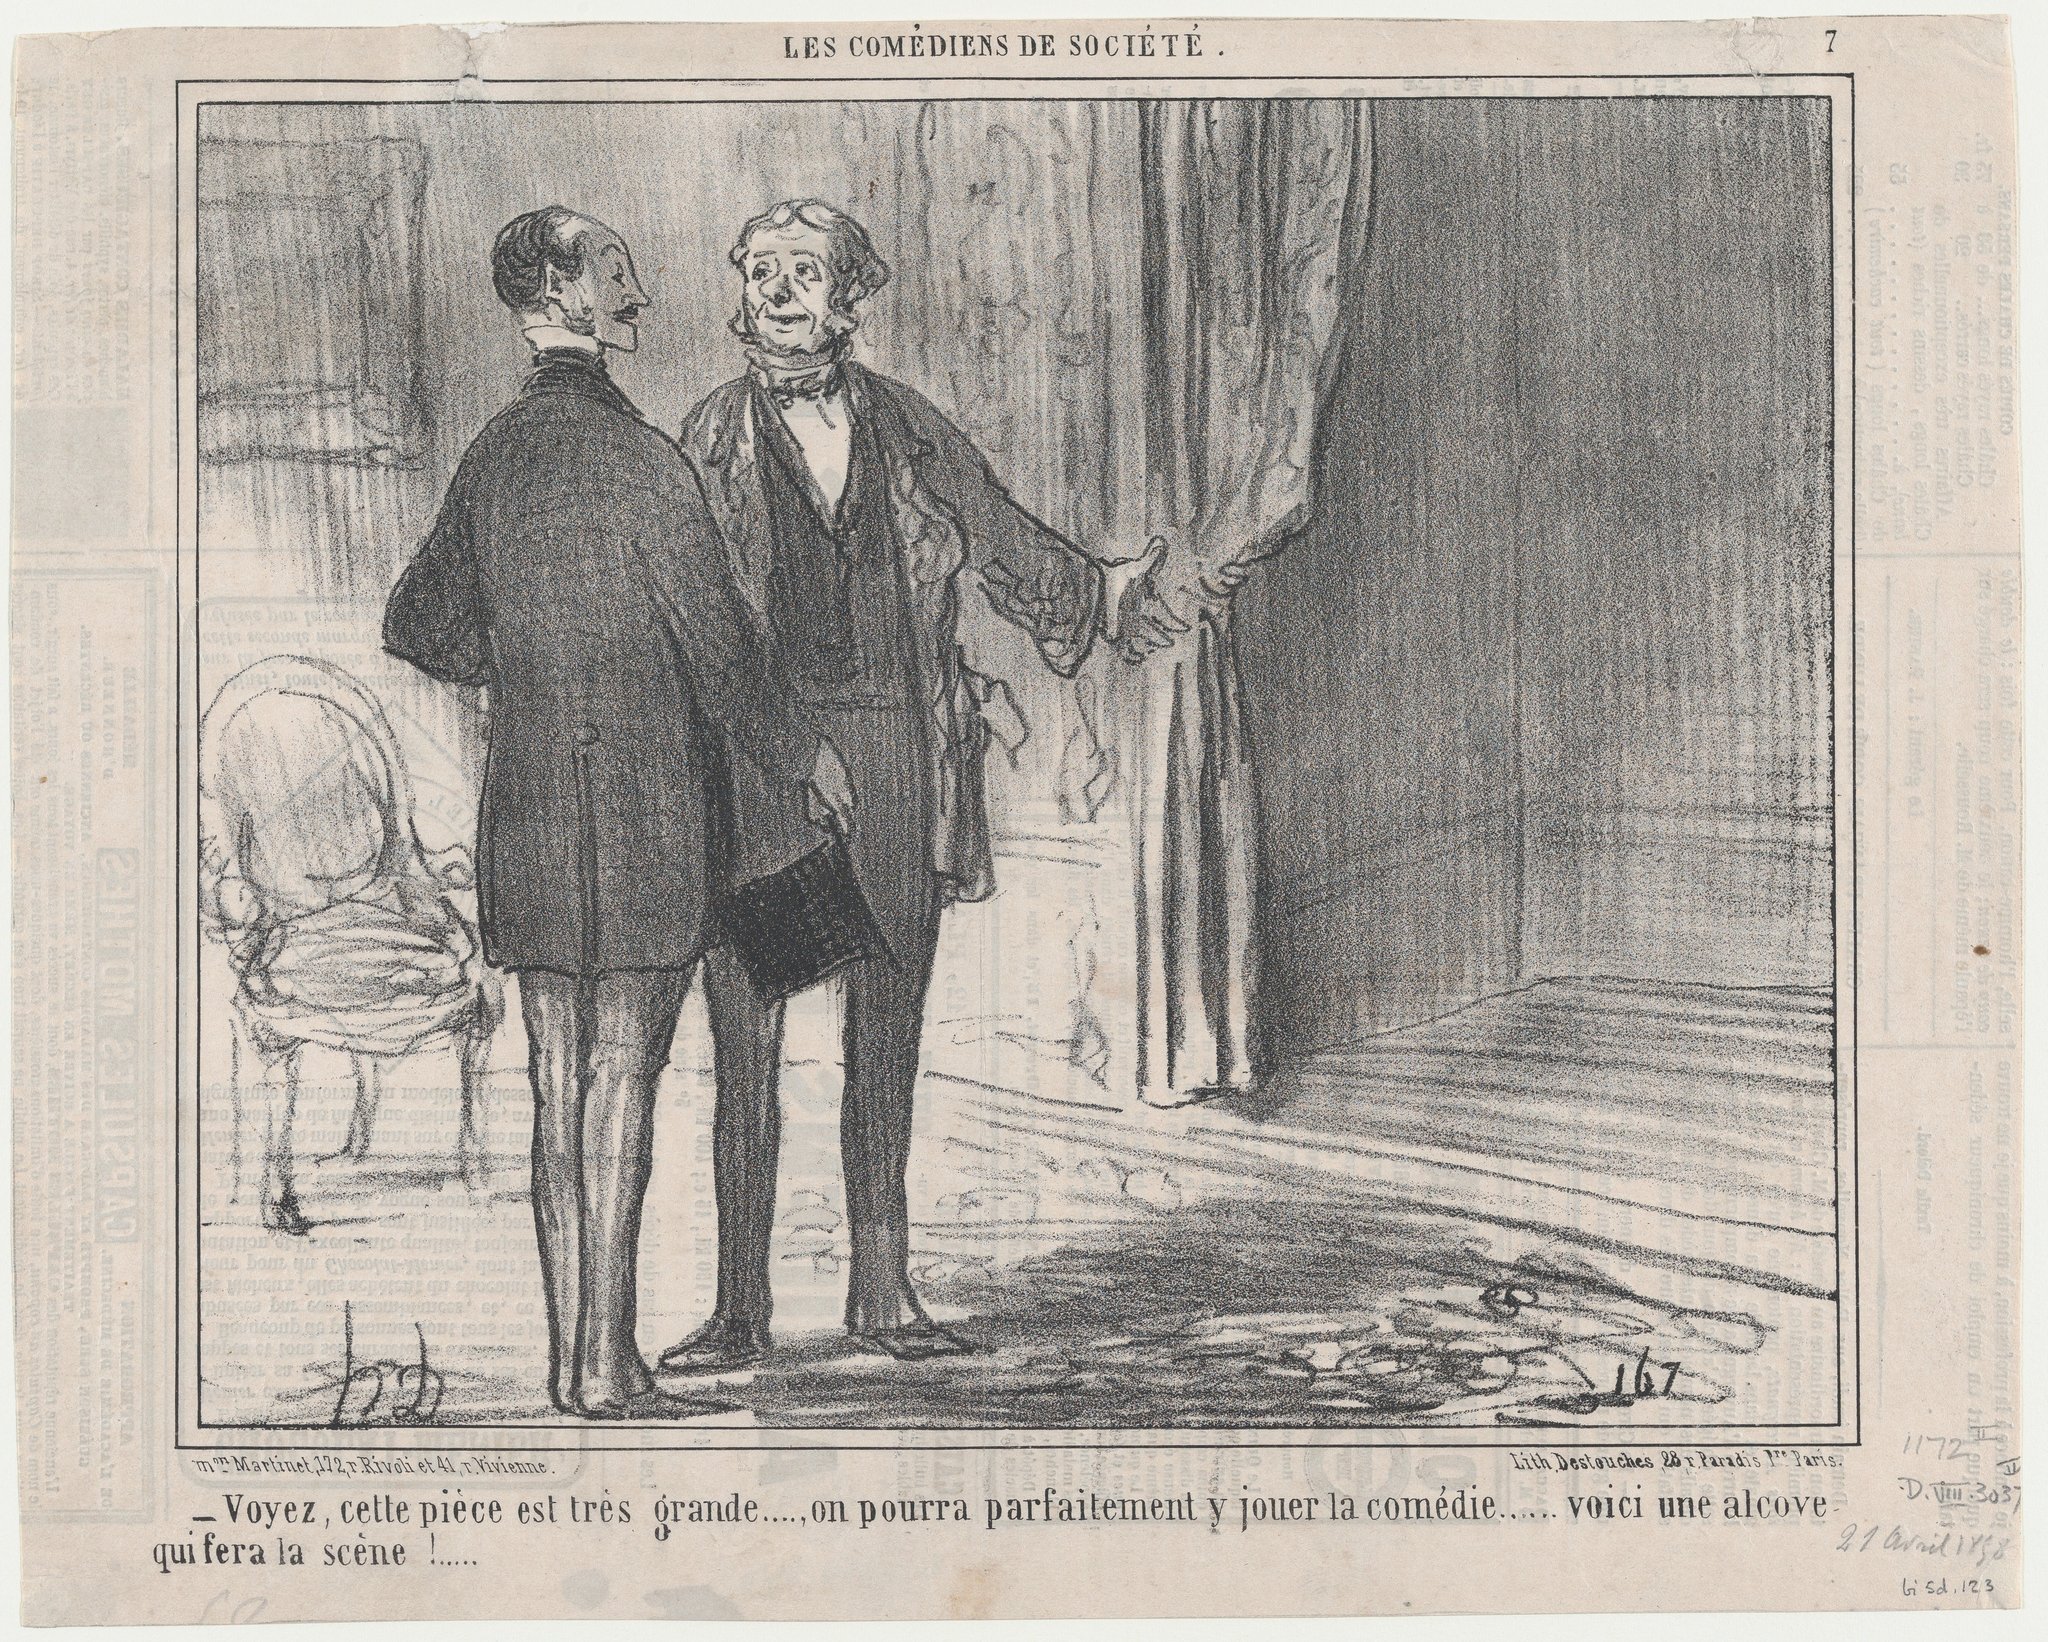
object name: print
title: Voyez, cette pièce est très grande..., from Les Comédiens de Société, published in Le Charivari, April 27, 1858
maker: honoré daumier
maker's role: artist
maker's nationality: french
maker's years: 1808-1879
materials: paper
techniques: lithograph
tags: men